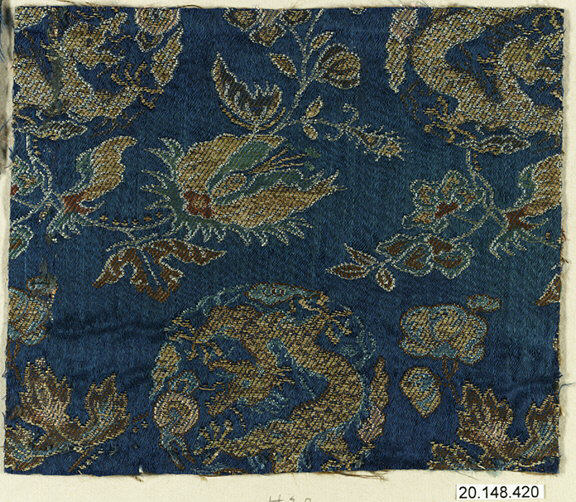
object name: piece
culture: chinese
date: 1701-1800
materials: silk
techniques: compound weave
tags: dragons,flowers,leaves